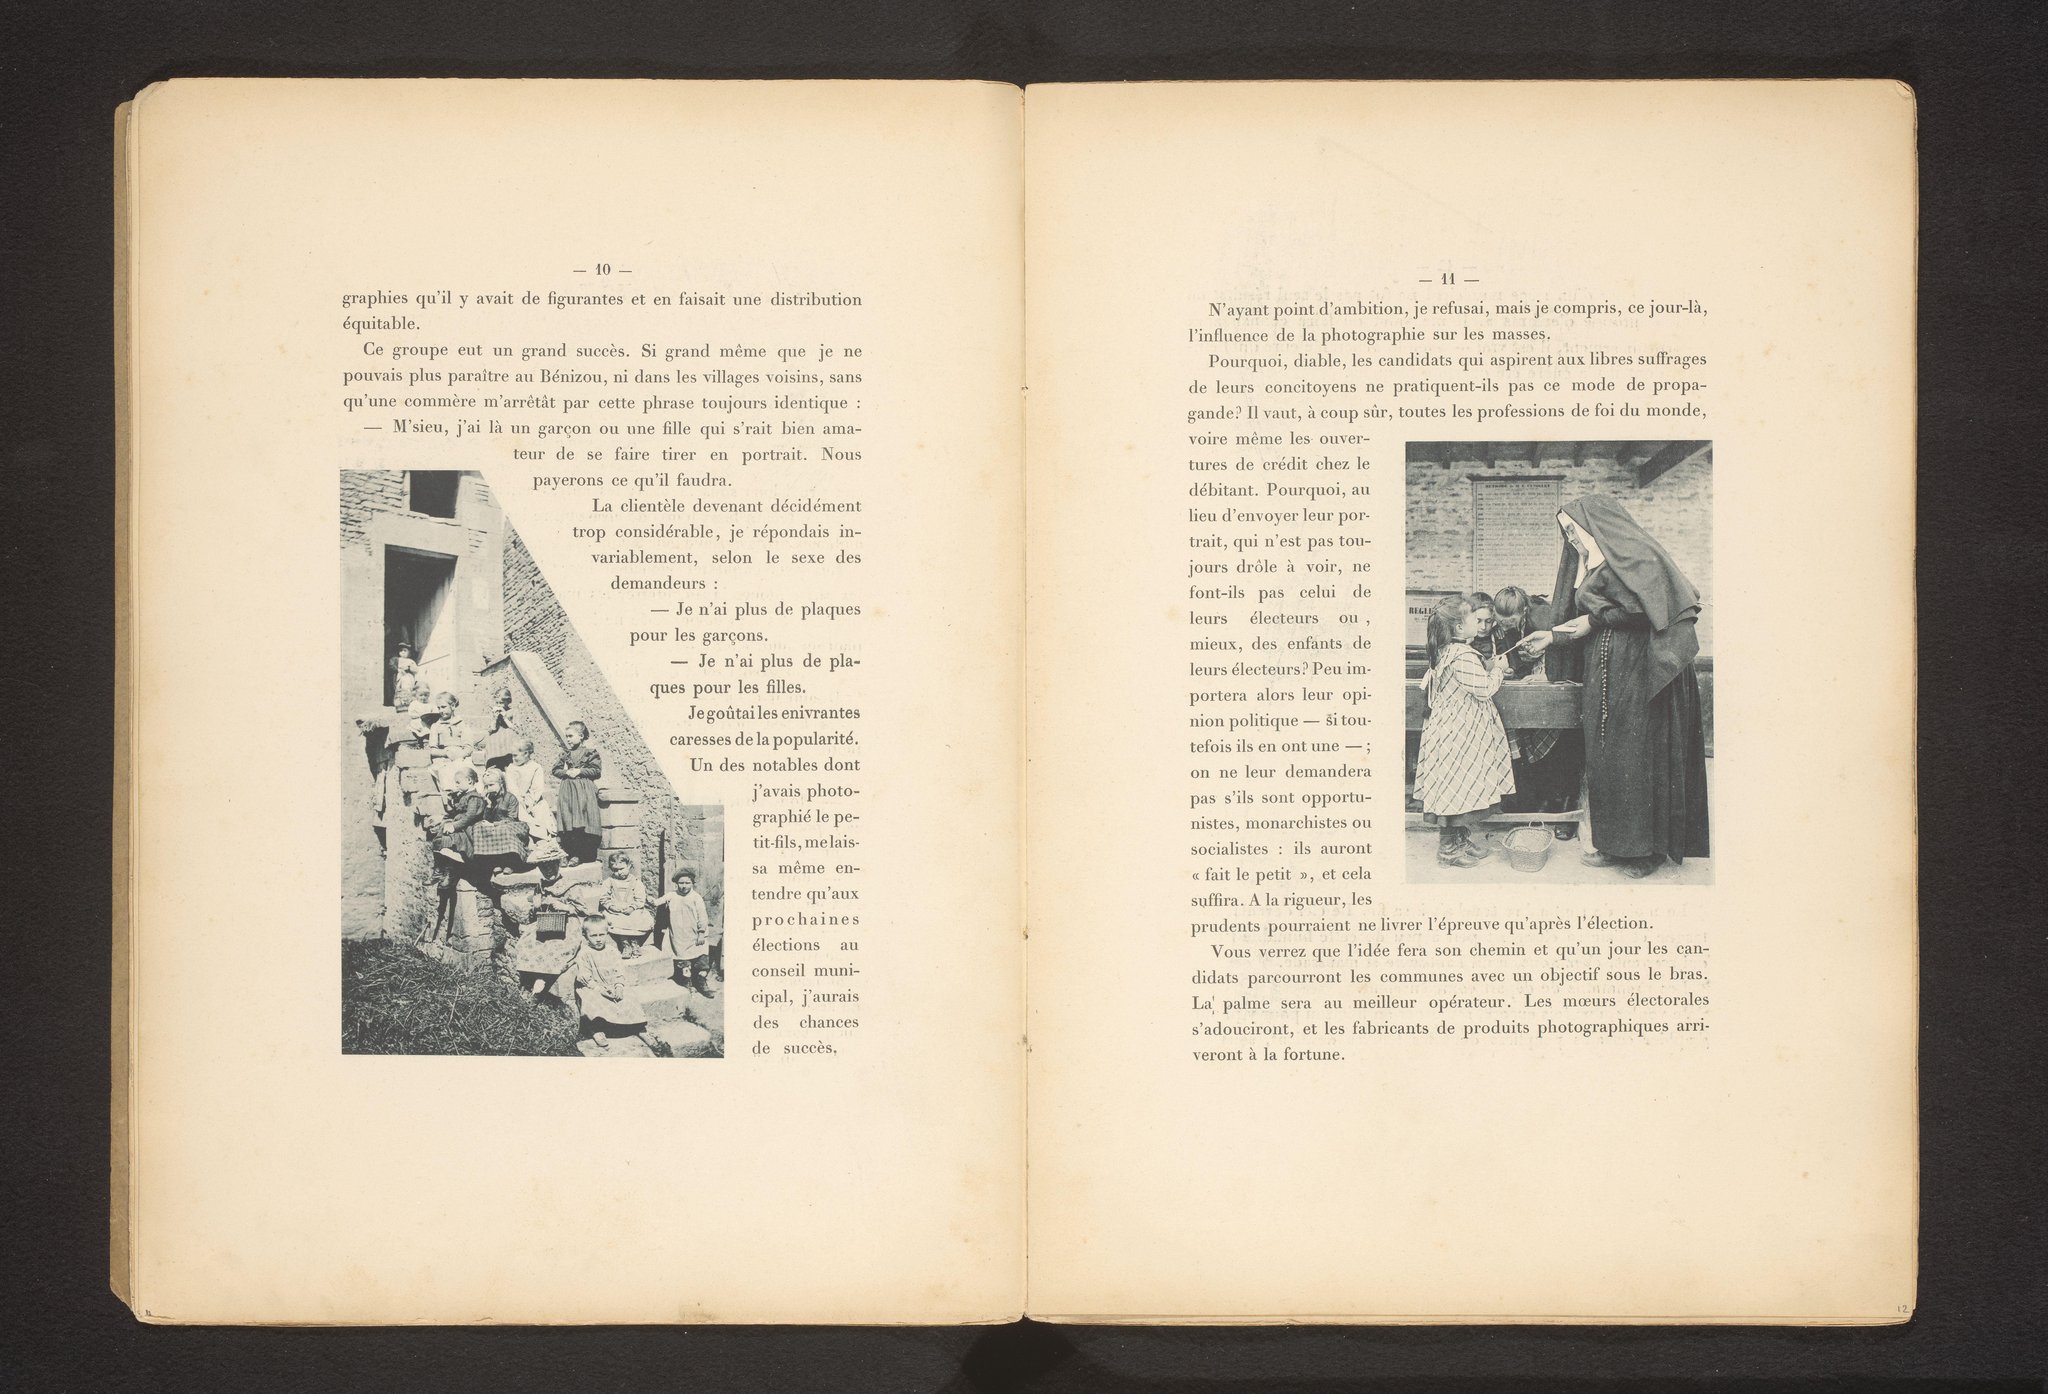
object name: page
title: Non die een meisje iets geeft, daar achter twee meisjes die naar een tafel kijken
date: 1885-1895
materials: paper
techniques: photograph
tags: nun(s), girl (child between toddler and youth)